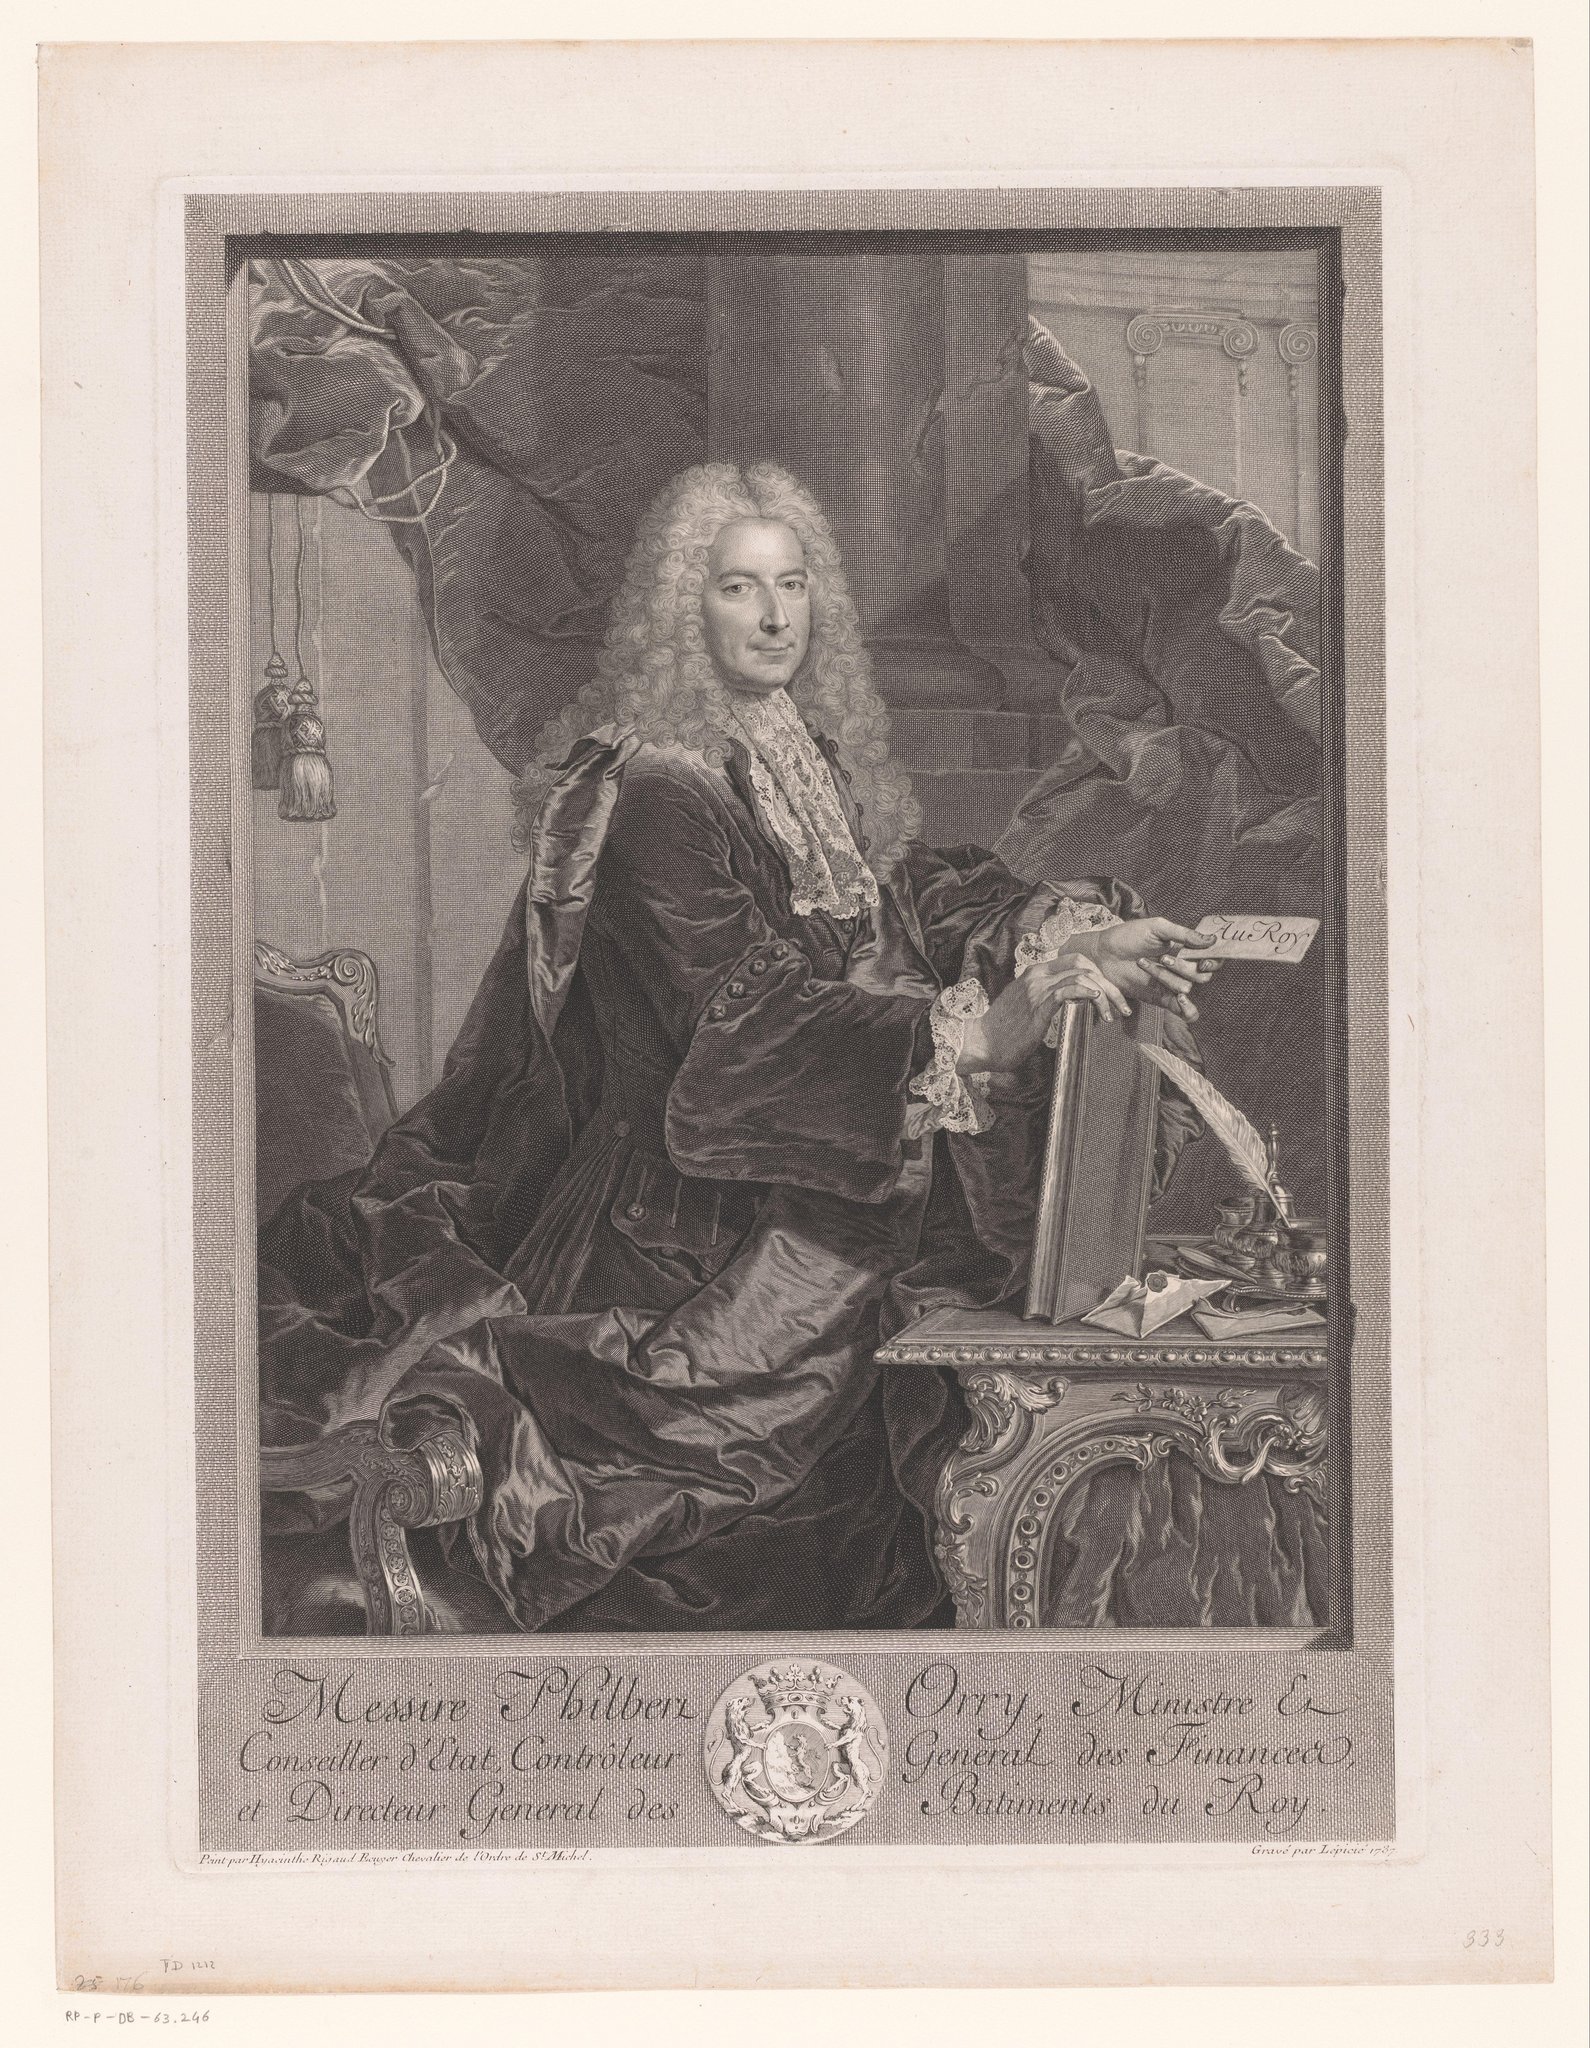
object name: print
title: Portret van Philbert Orry met een brief voor de koning in zijn hand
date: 1737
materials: paper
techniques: engraving, etching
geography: france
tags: philibert orry, minister ~ government, historical persons, wig, letter, envelope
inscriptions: collector's mark: Lugt 240